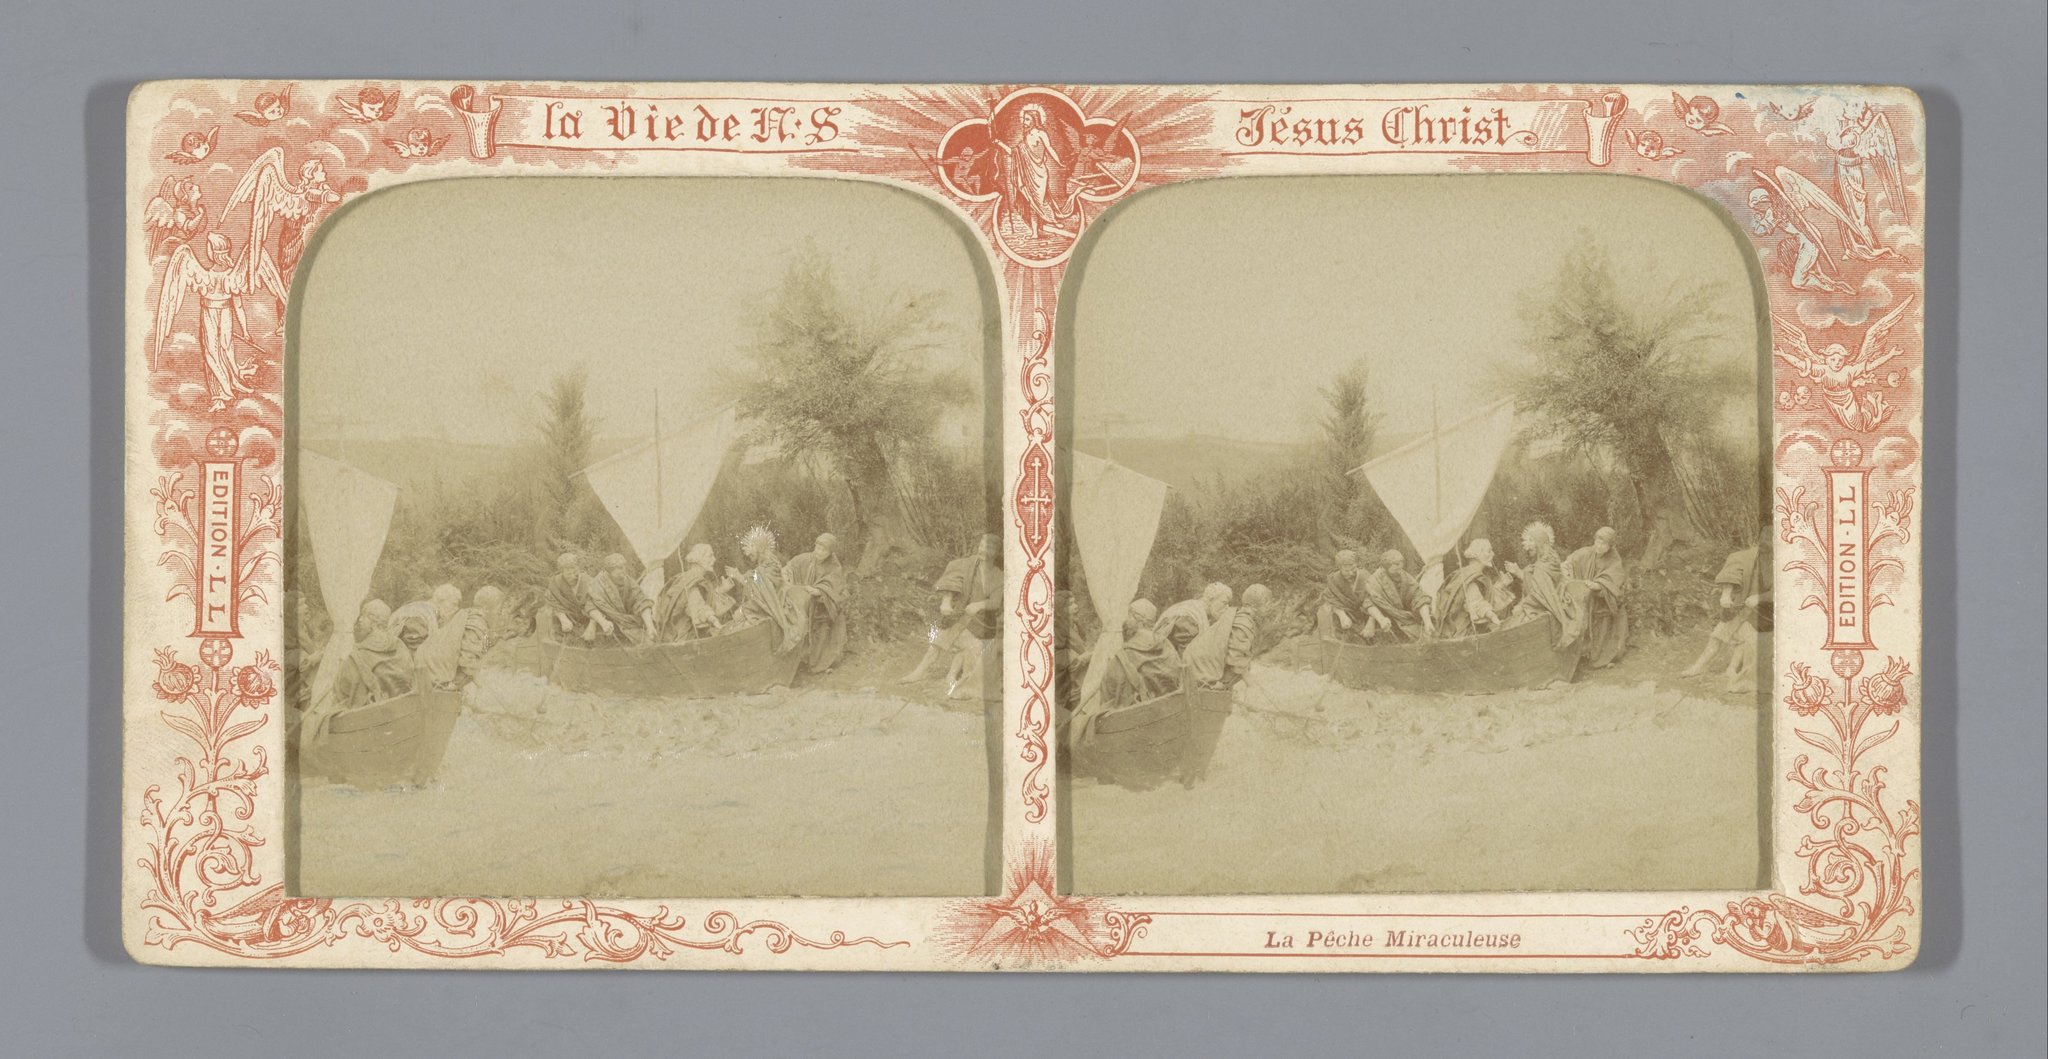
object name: tissue stereograph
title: La vie de NS Jésus Christ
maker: Anonymous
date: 1864-1905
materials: cardboard, paper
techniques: albumen print, cutting, hand coloring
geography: paris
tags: the miraculous draught of fishes (before the resurrection) on the lake of gennesaret (sea of galilee); james and john helping to bring in the nets (luke 5:1-11)